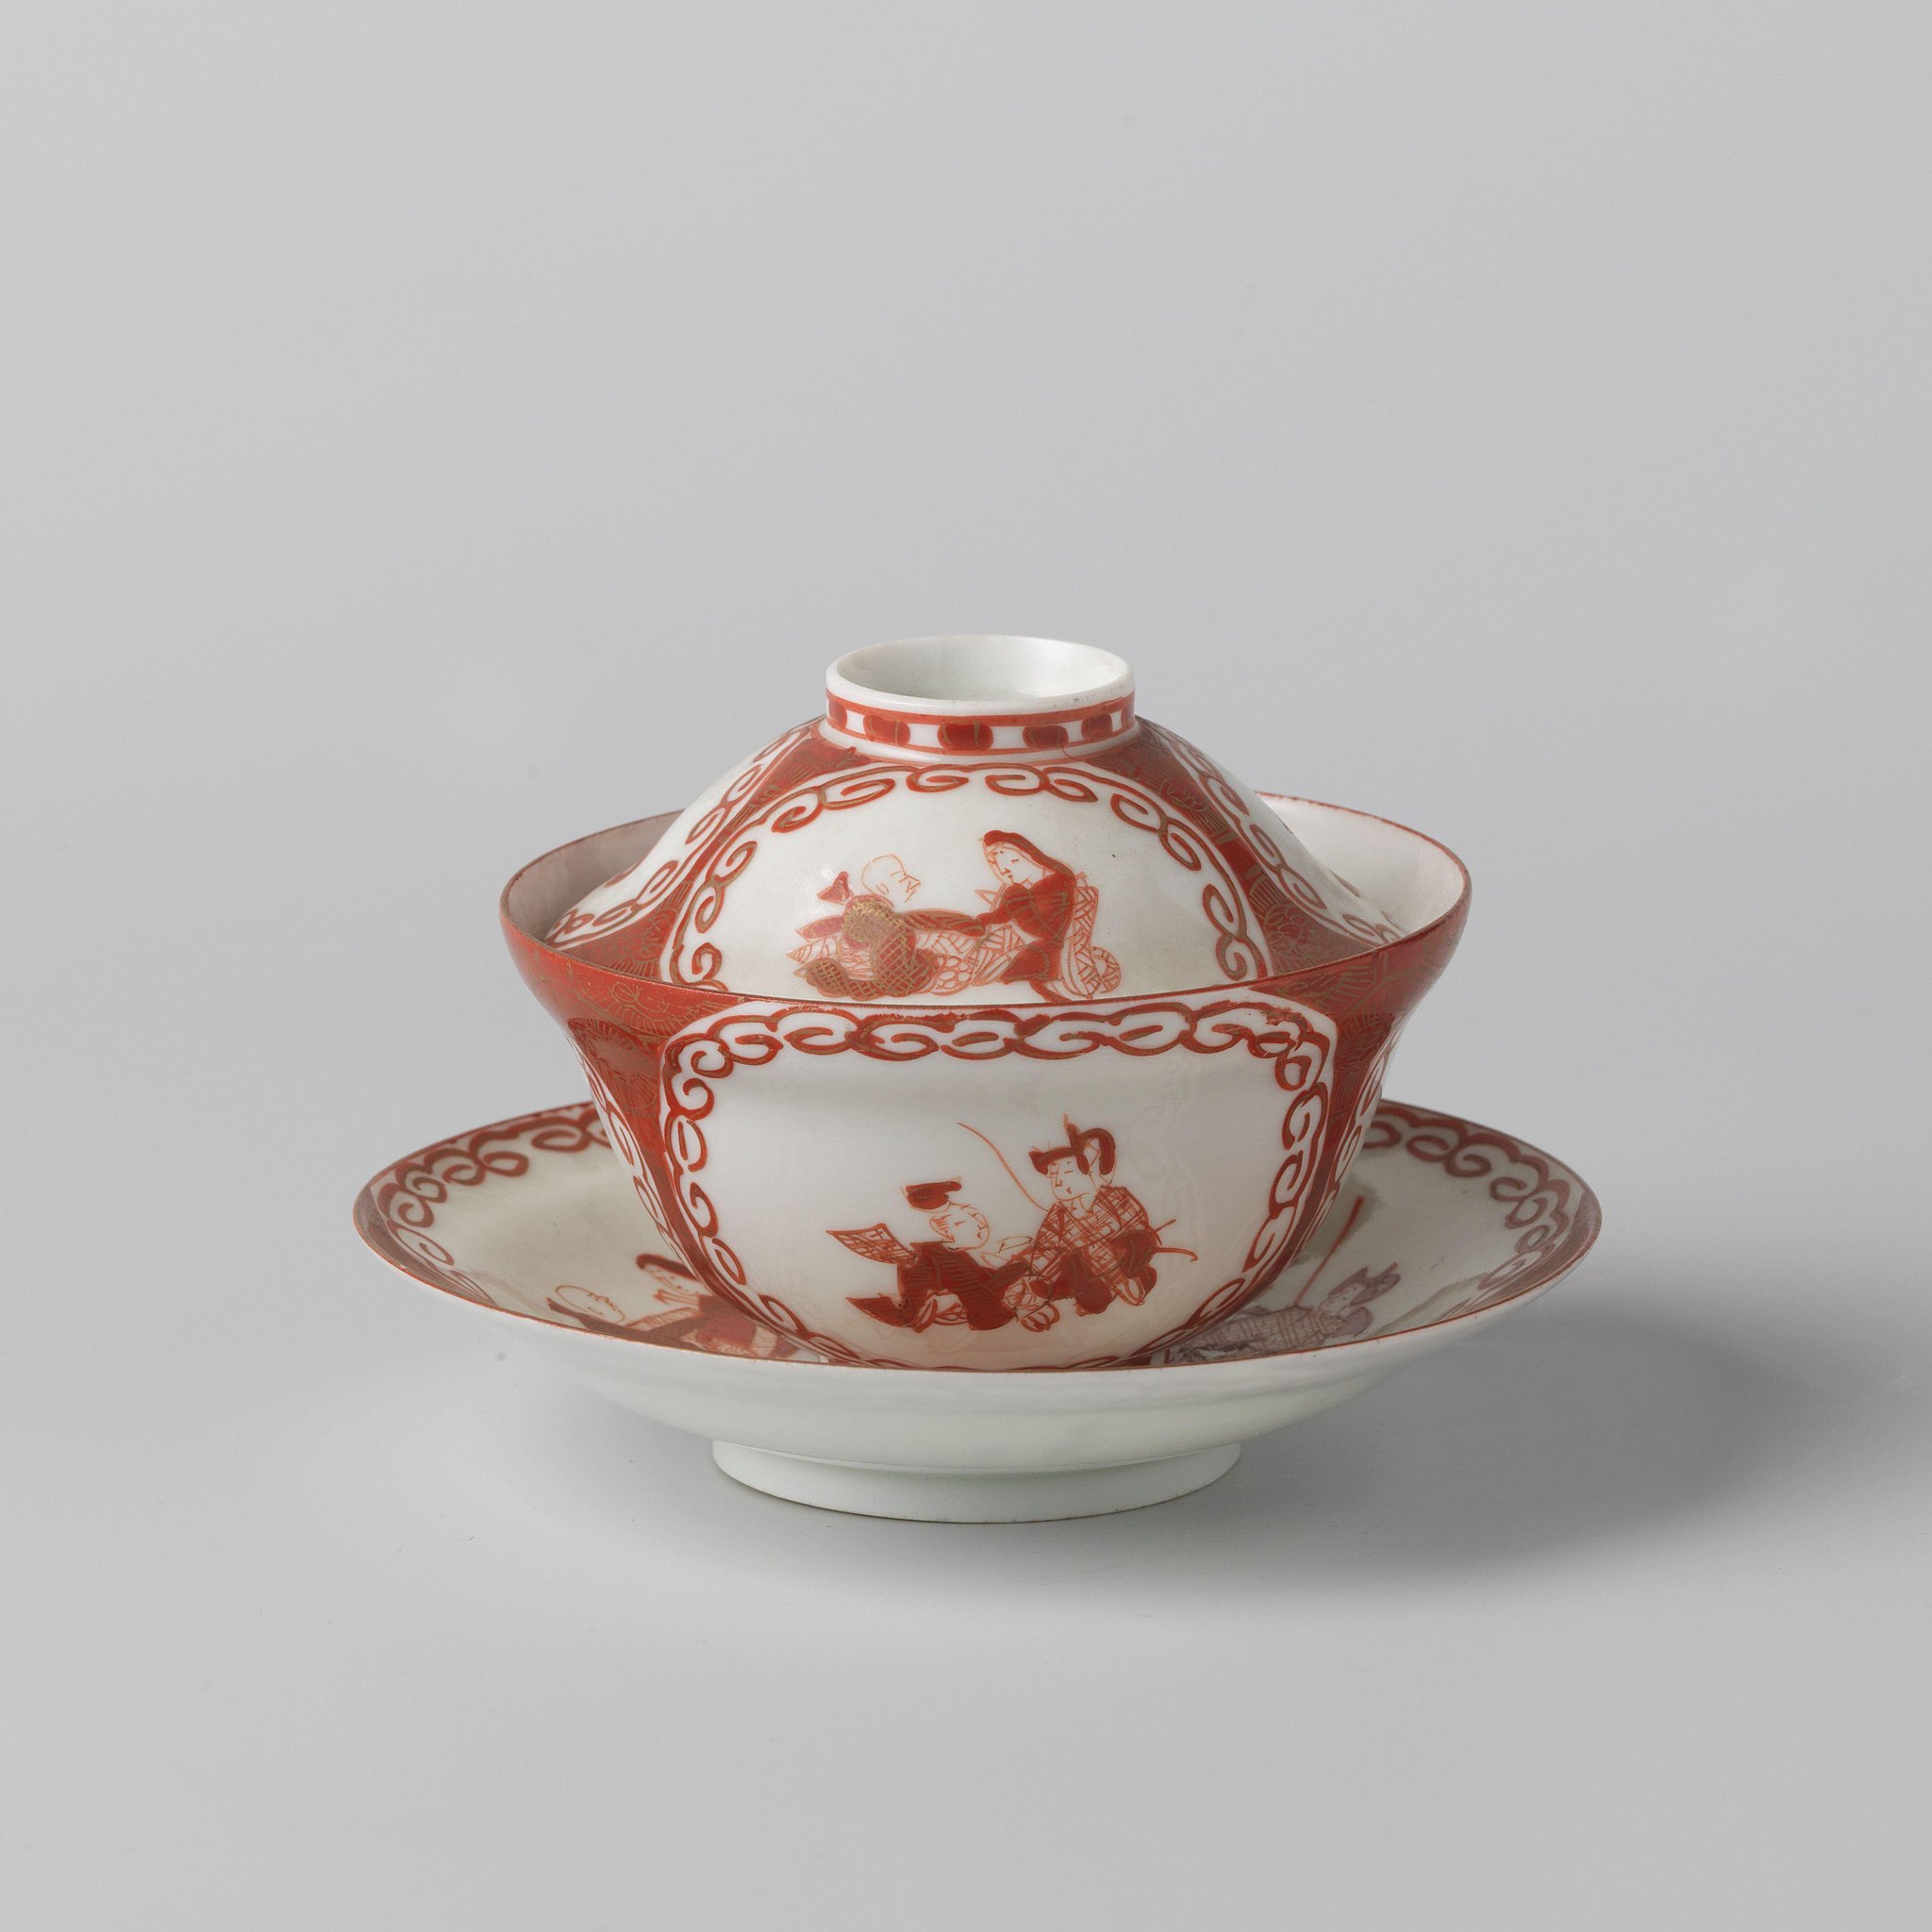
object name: kop en schotel, kop en schotel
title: Saucer with three panels with two seated figures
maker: Anonymous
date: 1800-1899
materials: glaze, gold, paint, porcelain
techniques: firing, gilding, turning, vitrification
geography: japan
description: Schotel van porselein met een ringvormige knop, beschilderd op het glazuur in rood en goud. Op de voorzijde van de schotel drie cartouches met telkens twee zittende mensen omgeven door een band krulwerk; tussen de cartouches een geometrisch patroon. Gemerkt op de onderzijde met drie ongeïdentificeerde karakters.